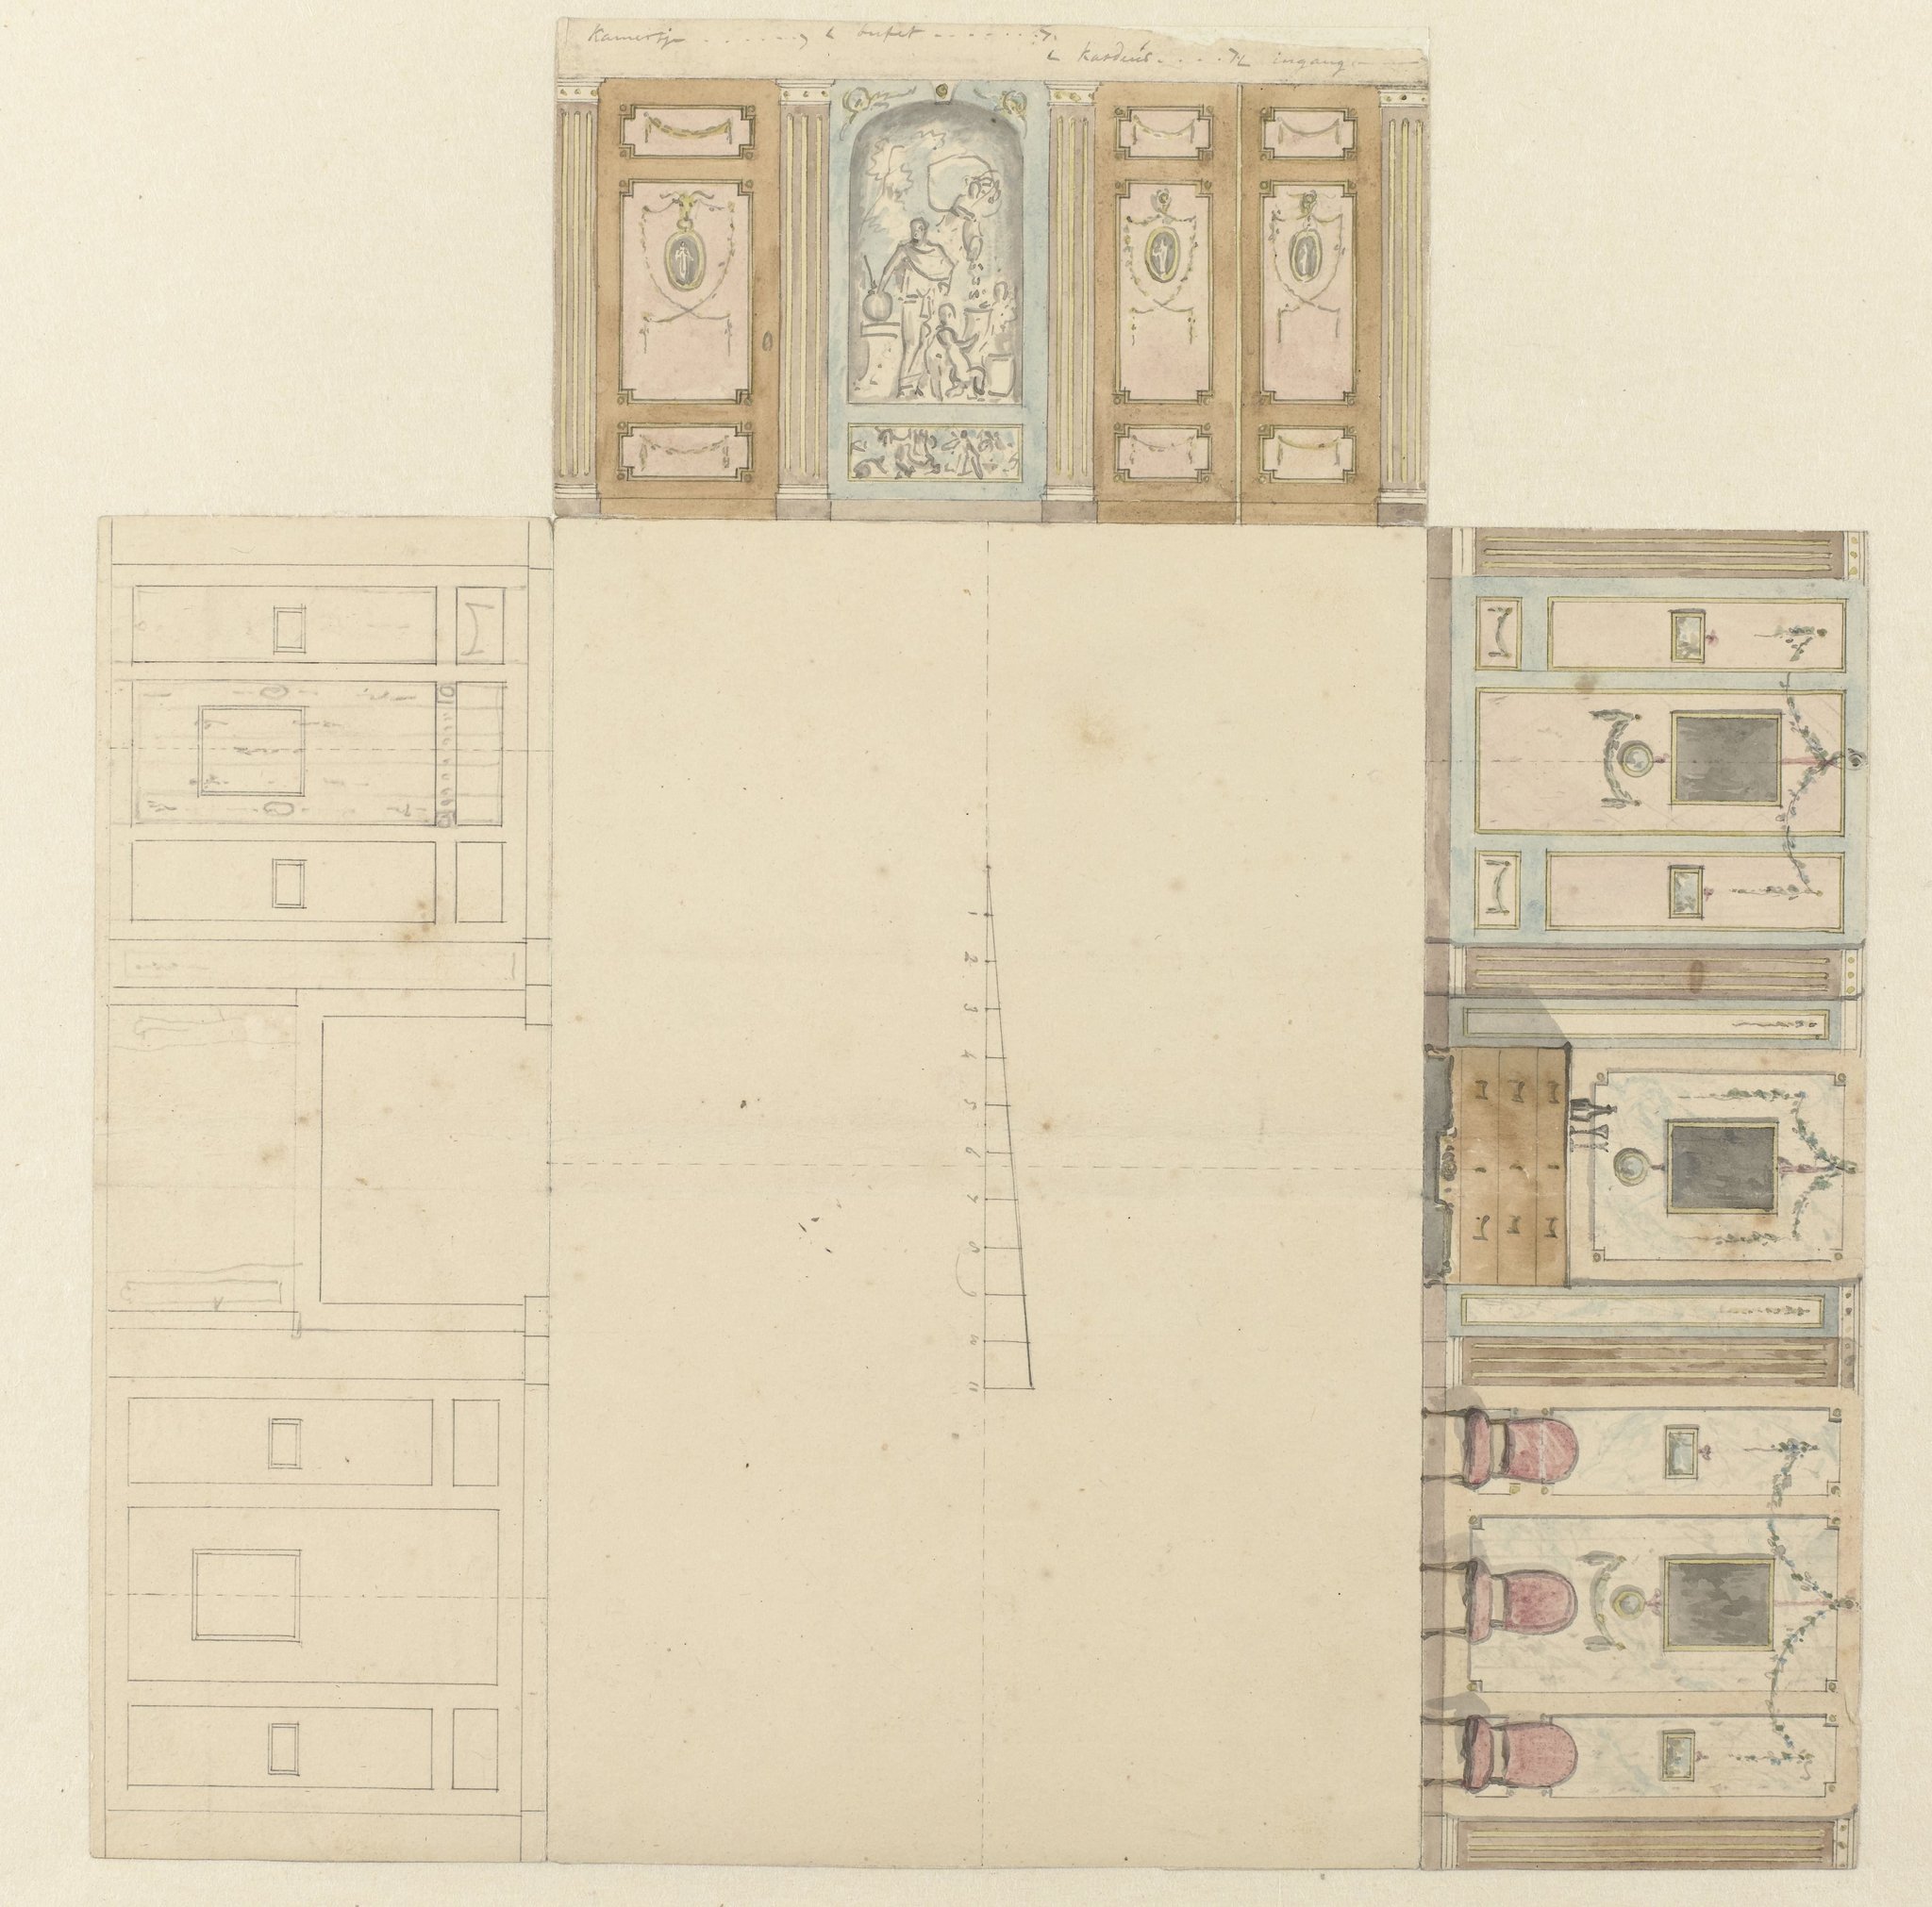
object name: design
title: Ontwerp voor de decoratie van drie wanden van een kamer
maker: jurriaan andriessen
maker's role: draughtsman, painter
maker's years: 1742-1819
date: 1752-1819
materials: graphite, ink, paper, watercolor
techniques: brush, pen